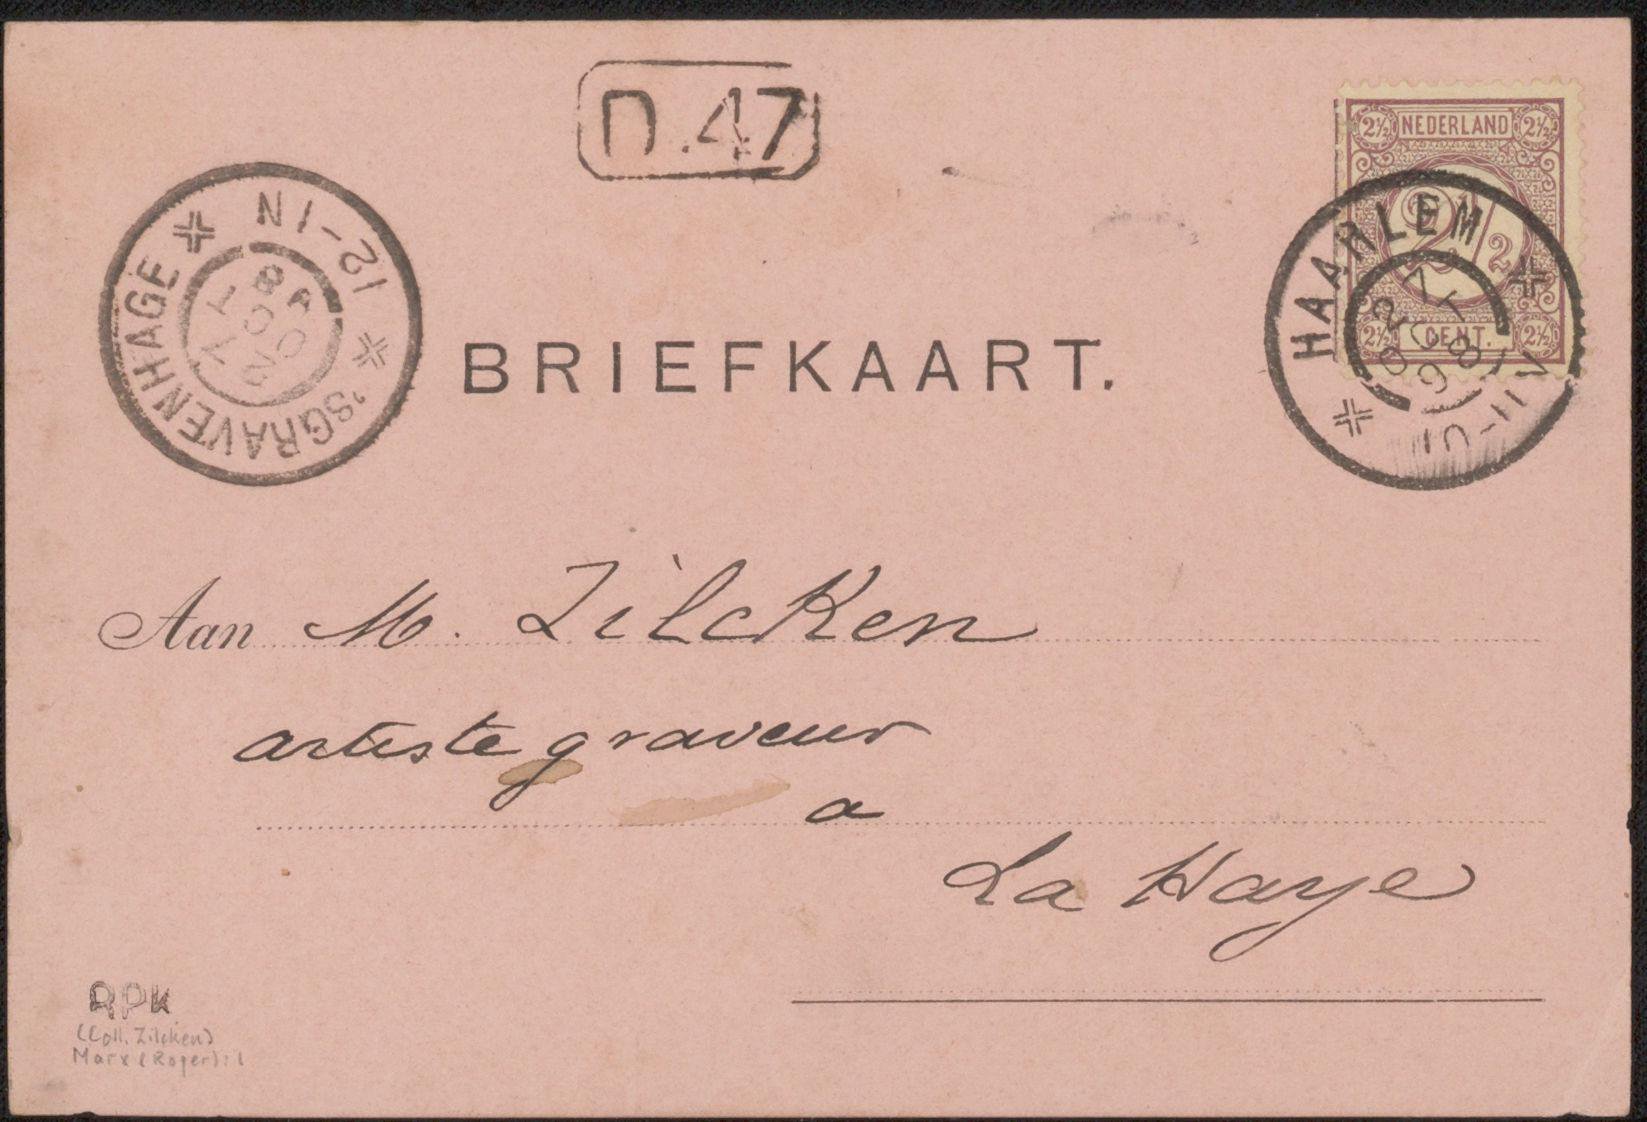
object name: postcard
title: Briefkaart aan Philip Zilcken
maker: roger marx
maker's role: kunstcriticus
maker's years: 1859-1913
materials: cardboard, ink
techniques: pen, writing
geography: amsterdam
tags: painter, draughtsman, philip zilcken, exhibition ~ art, the hague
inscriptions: collector's mark: ‘RPK’